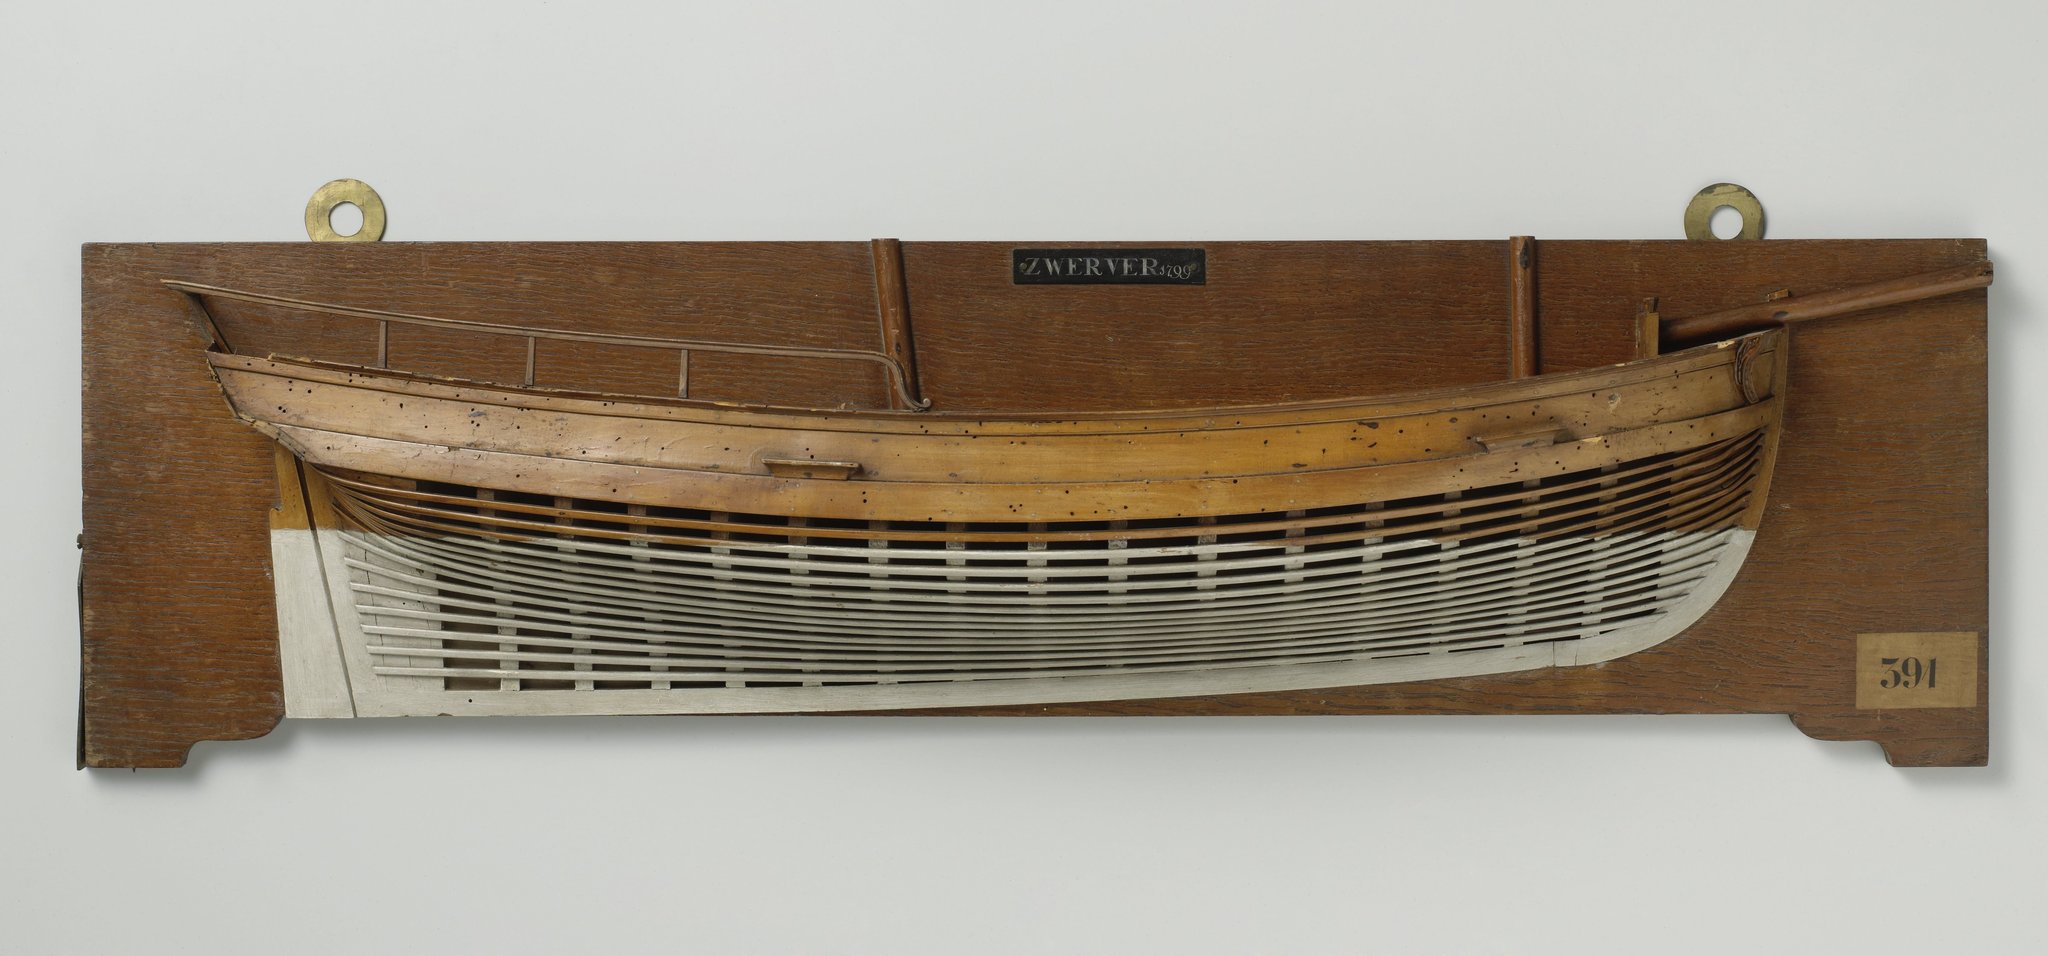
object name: builder's model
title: Half Model of a 4-Gun Schooner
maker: Anonymous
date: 1799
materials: wood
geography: rotterdam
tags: zwerver (schip)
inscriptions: label, bottom right: ‘391’ former inventory label, inscription, top centre, on a rectangular black label: ‘ZWERVER 1799’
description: Dit model is volgens de schoener van 4 stukken Zwerver, lang 80 voet, gebouwd door P. Glavimans Jz. te Rotterdam in 1799.